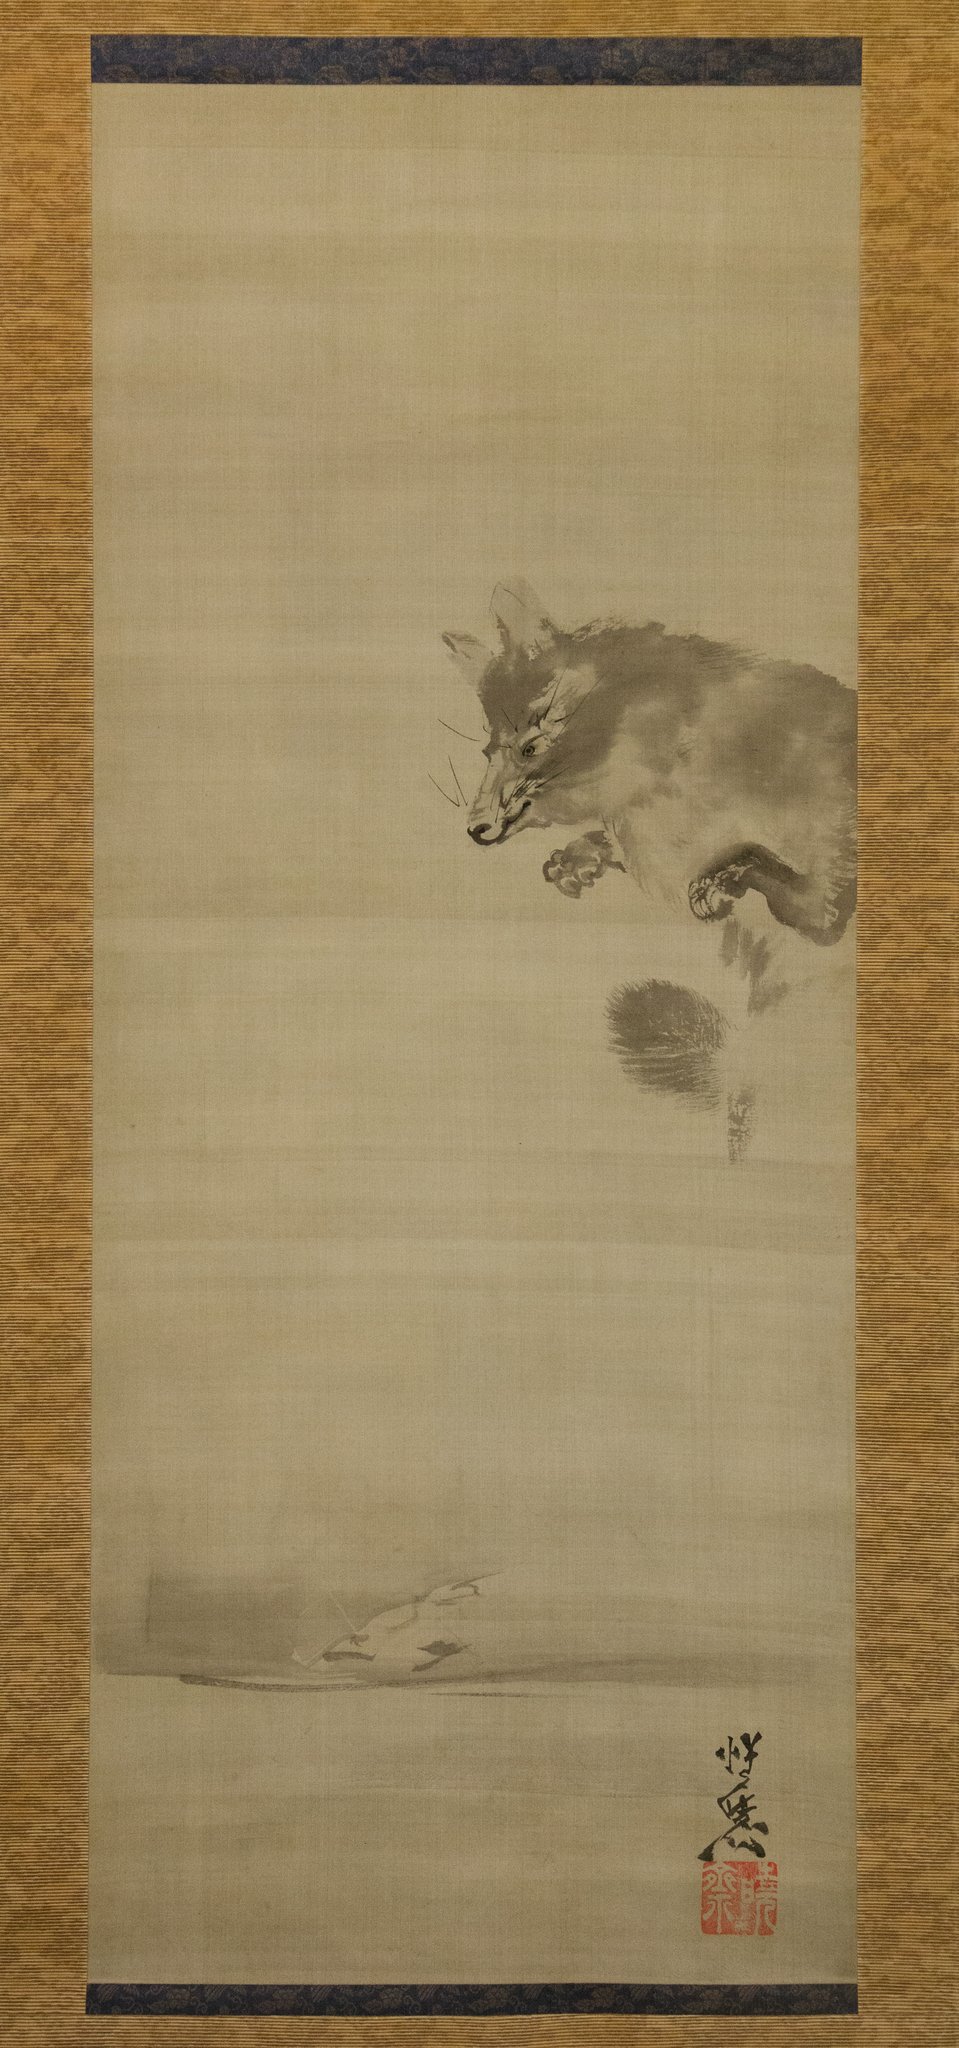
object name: hanging scroll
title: Tanuki (Racoon Dog) Viewing Its Reflection in Water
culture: japanese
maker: kawanabe kyōsai 河鍋暁斎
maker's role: artist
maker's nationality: japanese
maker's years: 1831-1889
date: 1867-1900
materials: ink, silk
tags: animals